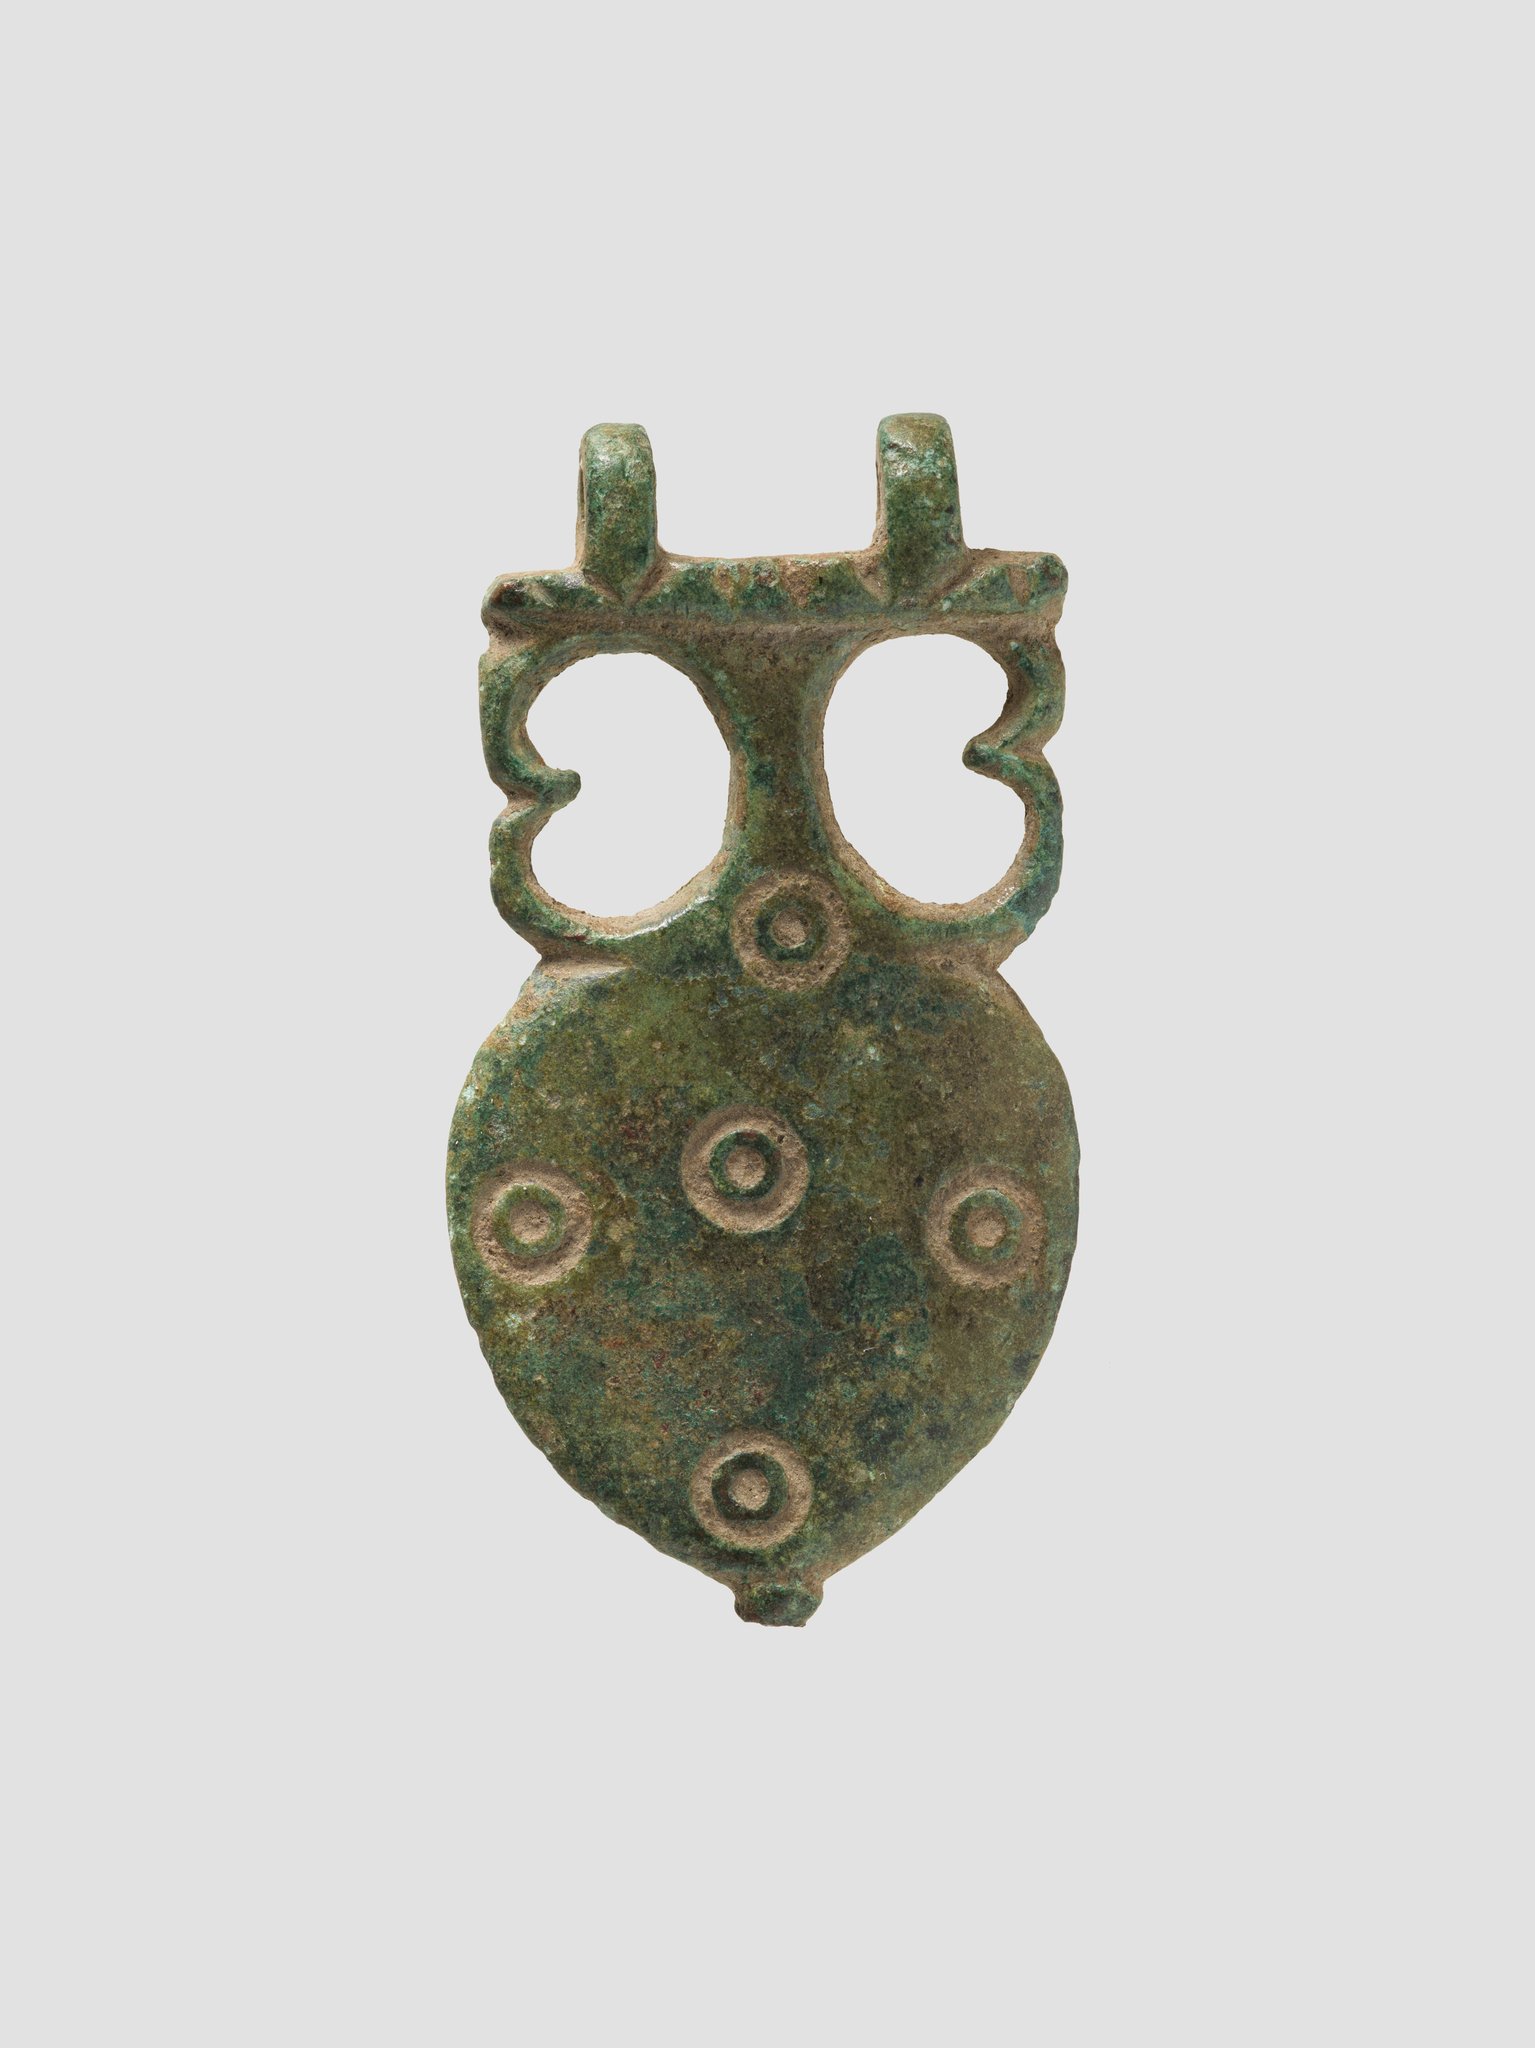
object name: belt buckle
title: Belt buckle or pendant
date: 1-1000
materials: bronze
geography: anatolia (?)